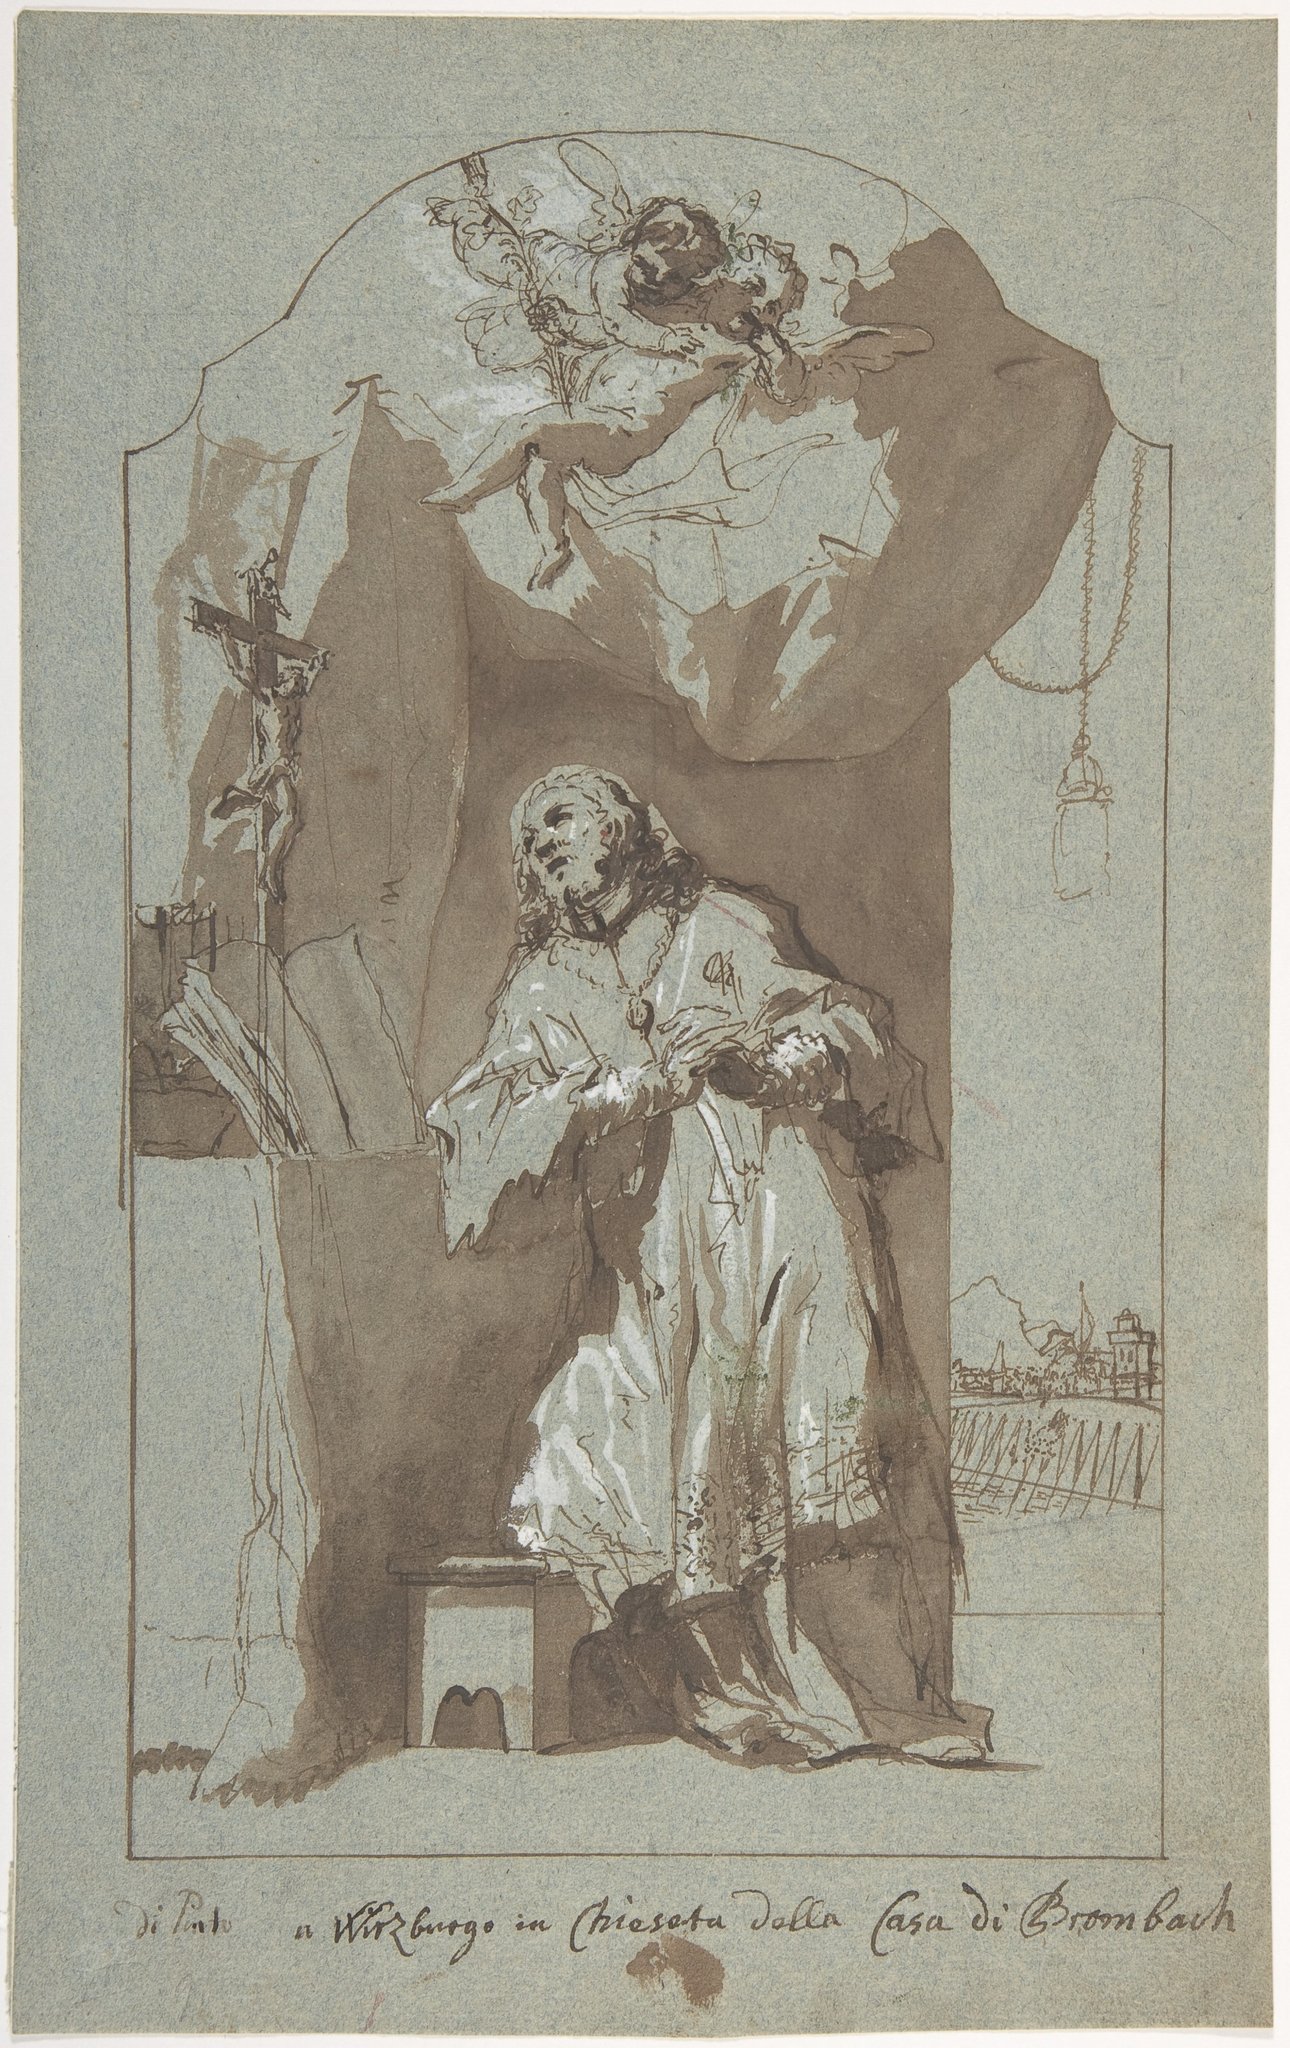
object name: drawing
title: Saint John Nepomuk Praying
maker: georg anton urlaub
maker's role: artist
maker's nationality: german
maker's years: 1713-1759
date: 1720-1759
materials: ink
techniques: heightening, pen, wash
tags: angels,christ,saint john the baptist,crucifixion